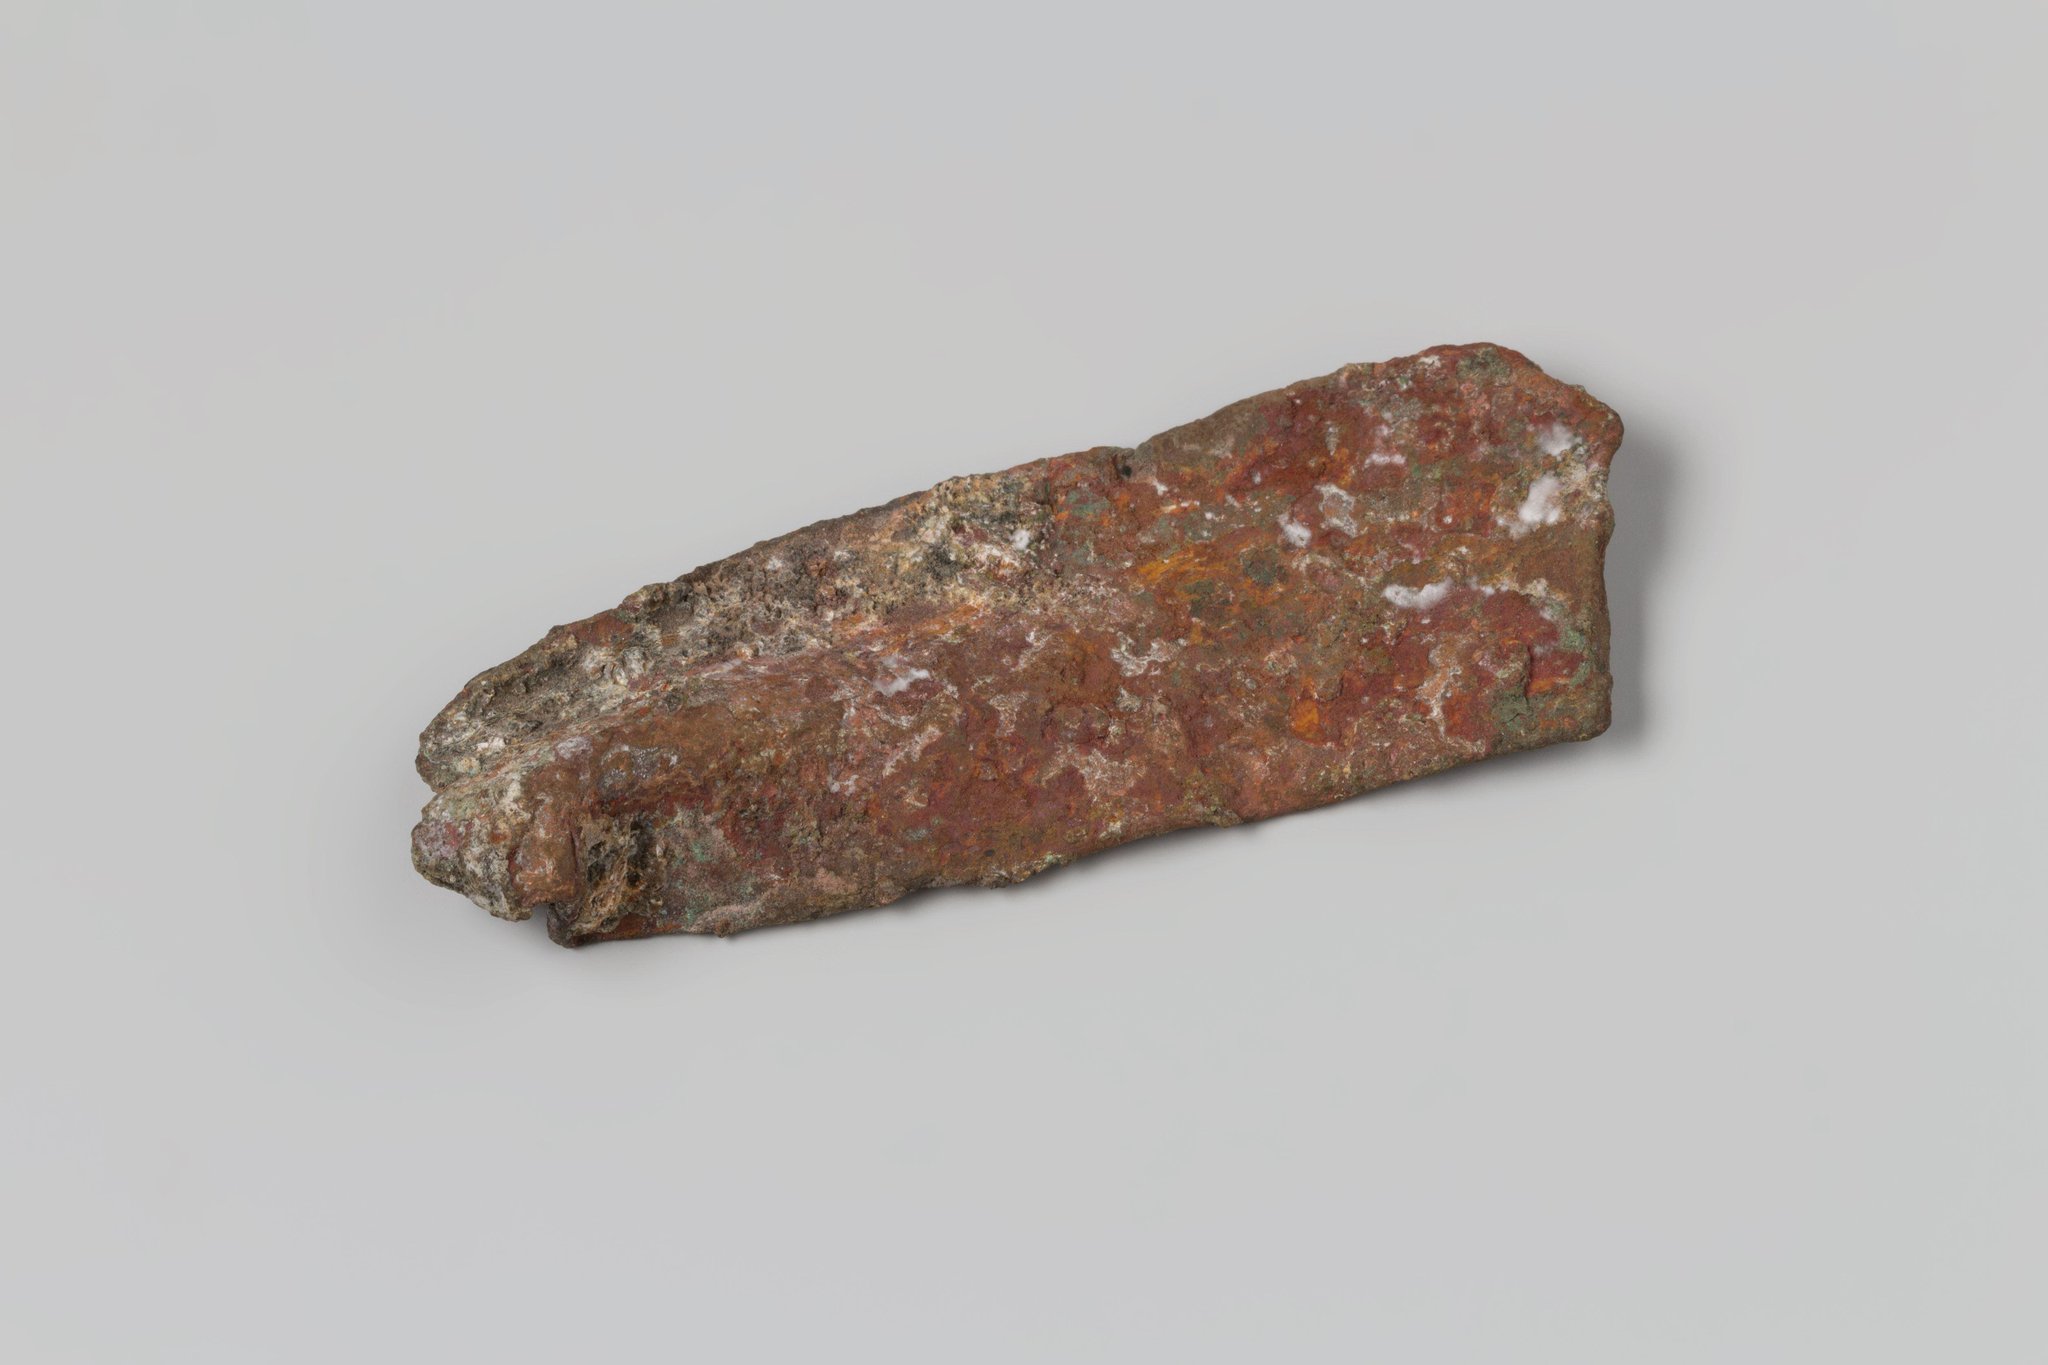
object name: scheepswrakvondst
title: Fragment van koper uit het wrak van de Oost-Indiëvaarder Hollandia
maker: Anonymous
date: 1700-1743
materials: copper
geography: netherlands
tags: verenigde oostindische compagnie, hollandia (schip), annet